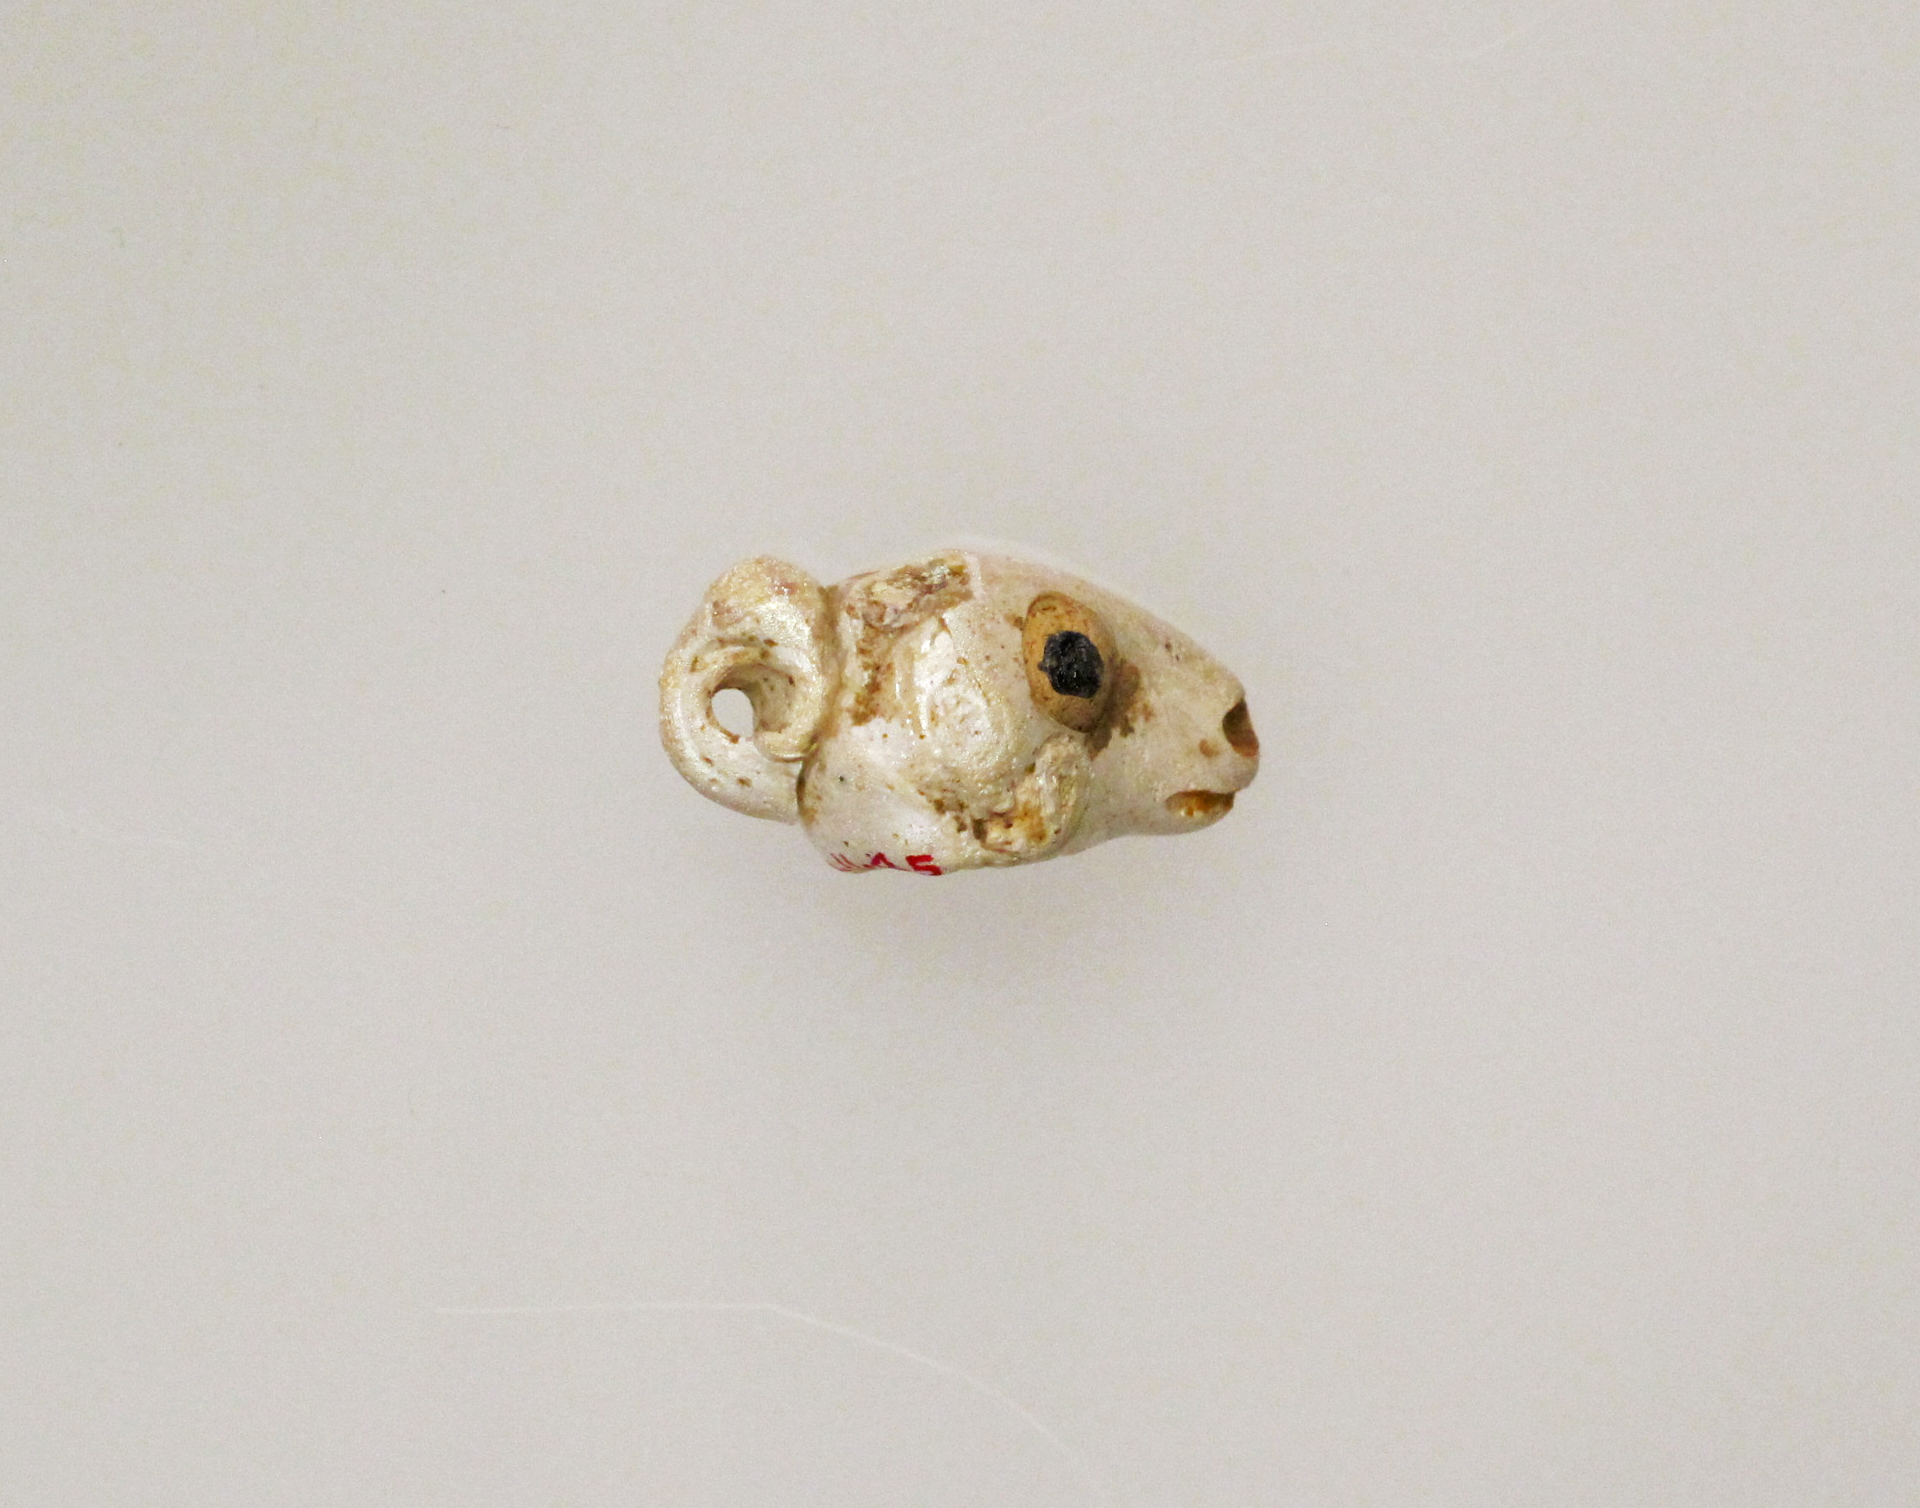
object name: pendant in the form of a ram's head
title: Glass pendant in the form of a ram's head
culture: carthaginian or phoenician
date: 400-301 BCE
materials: glass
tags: rams